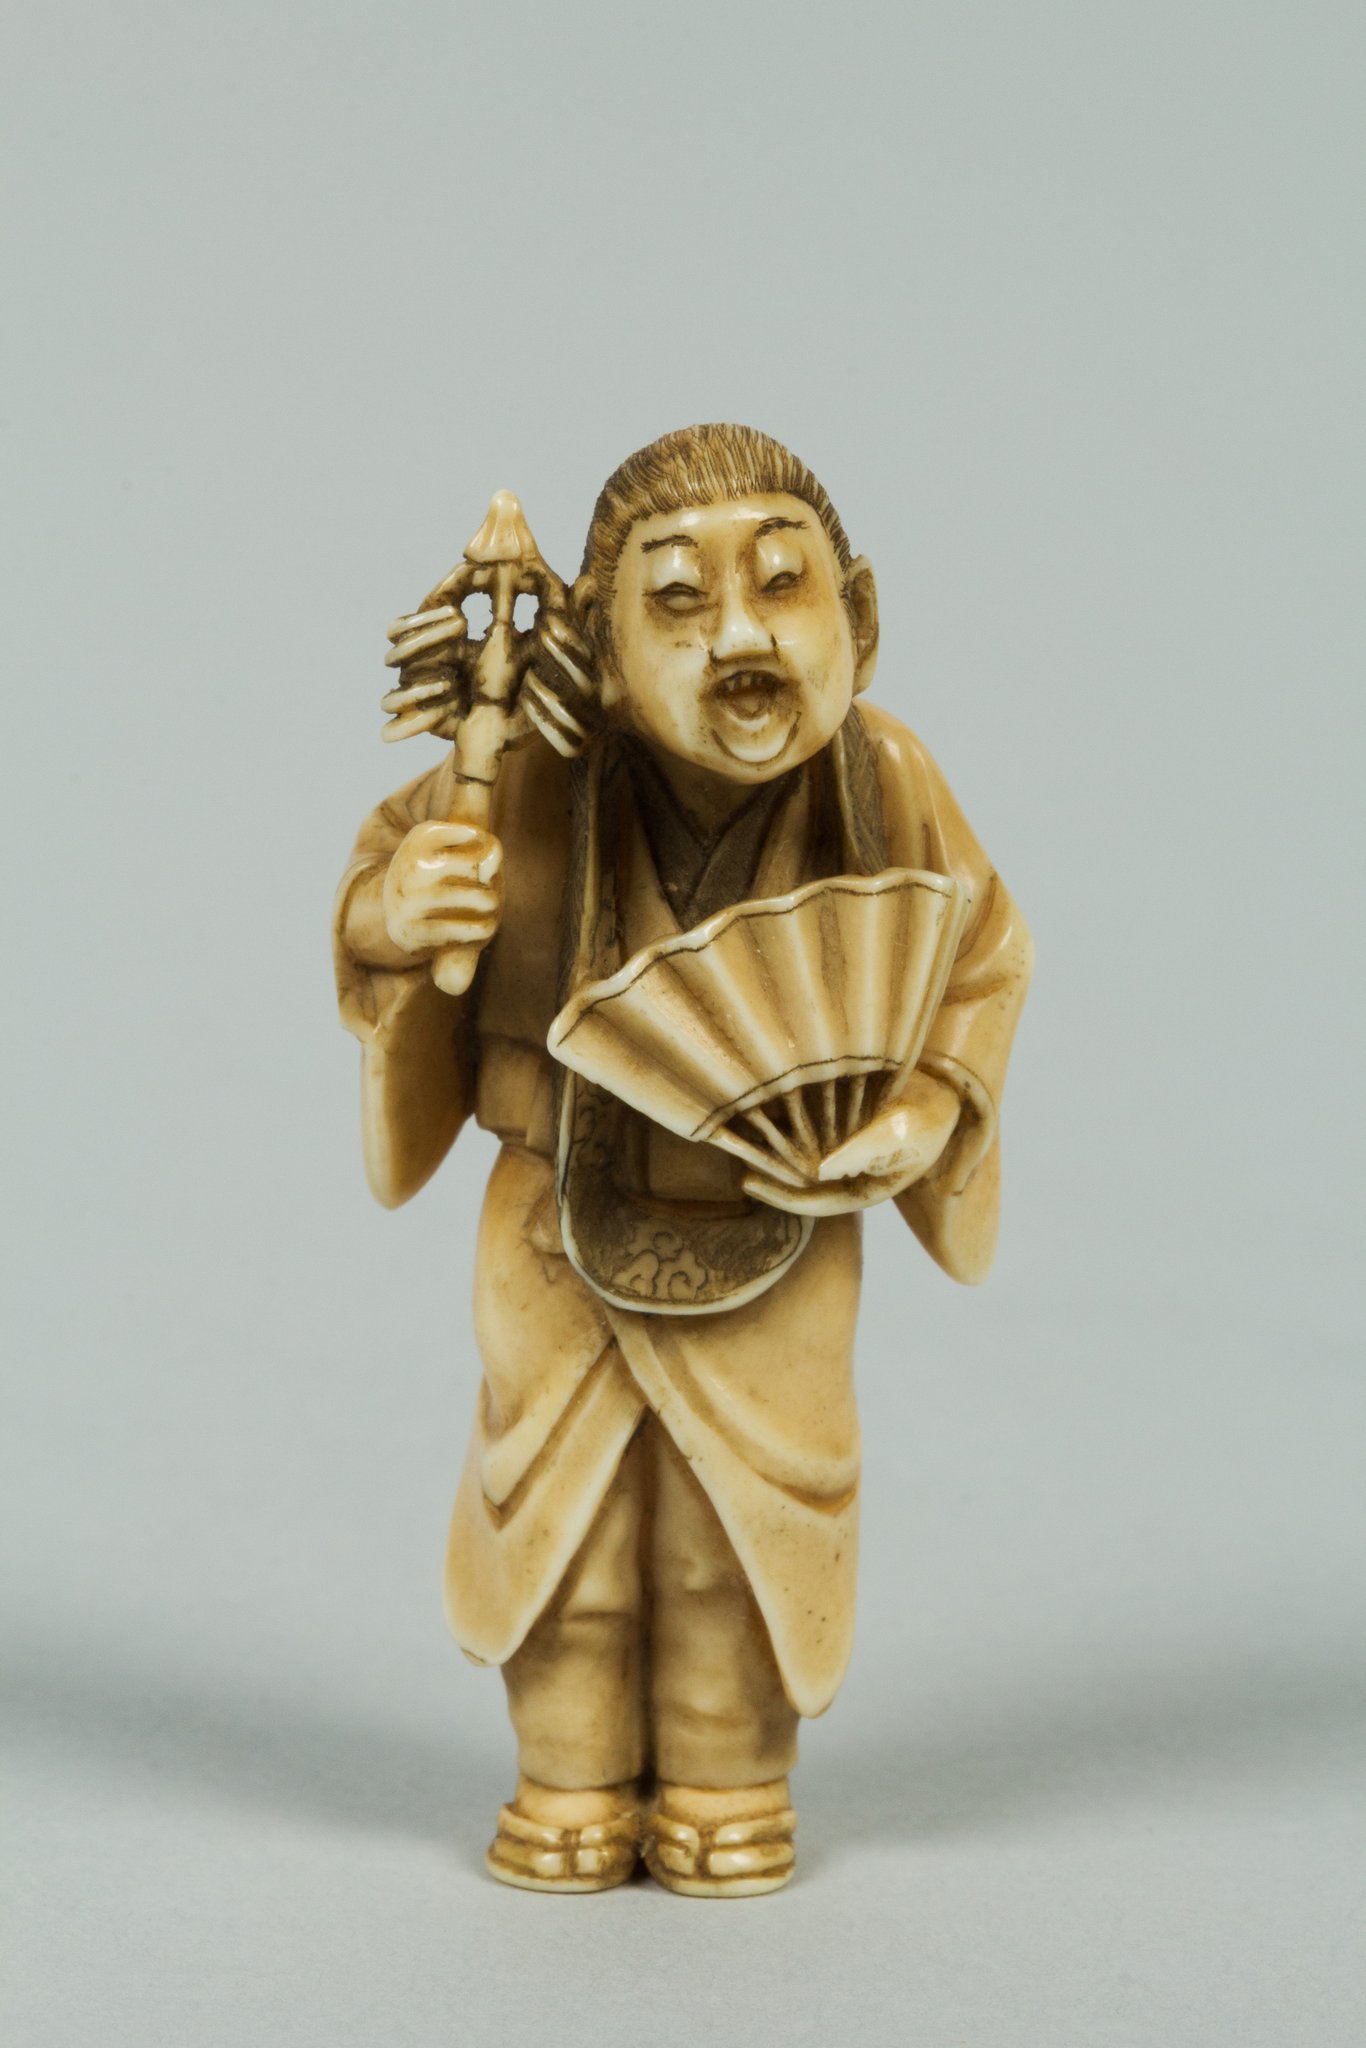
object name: netsuke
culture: japanese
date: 1801-1900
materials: ivory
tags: fans,men